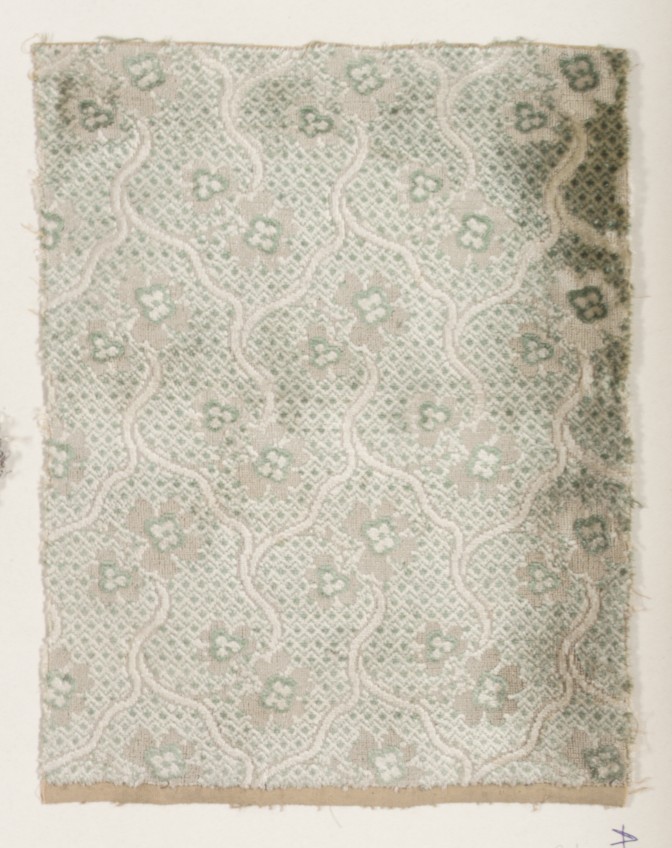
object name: fragment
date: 1701-1800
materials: silk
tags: flowers